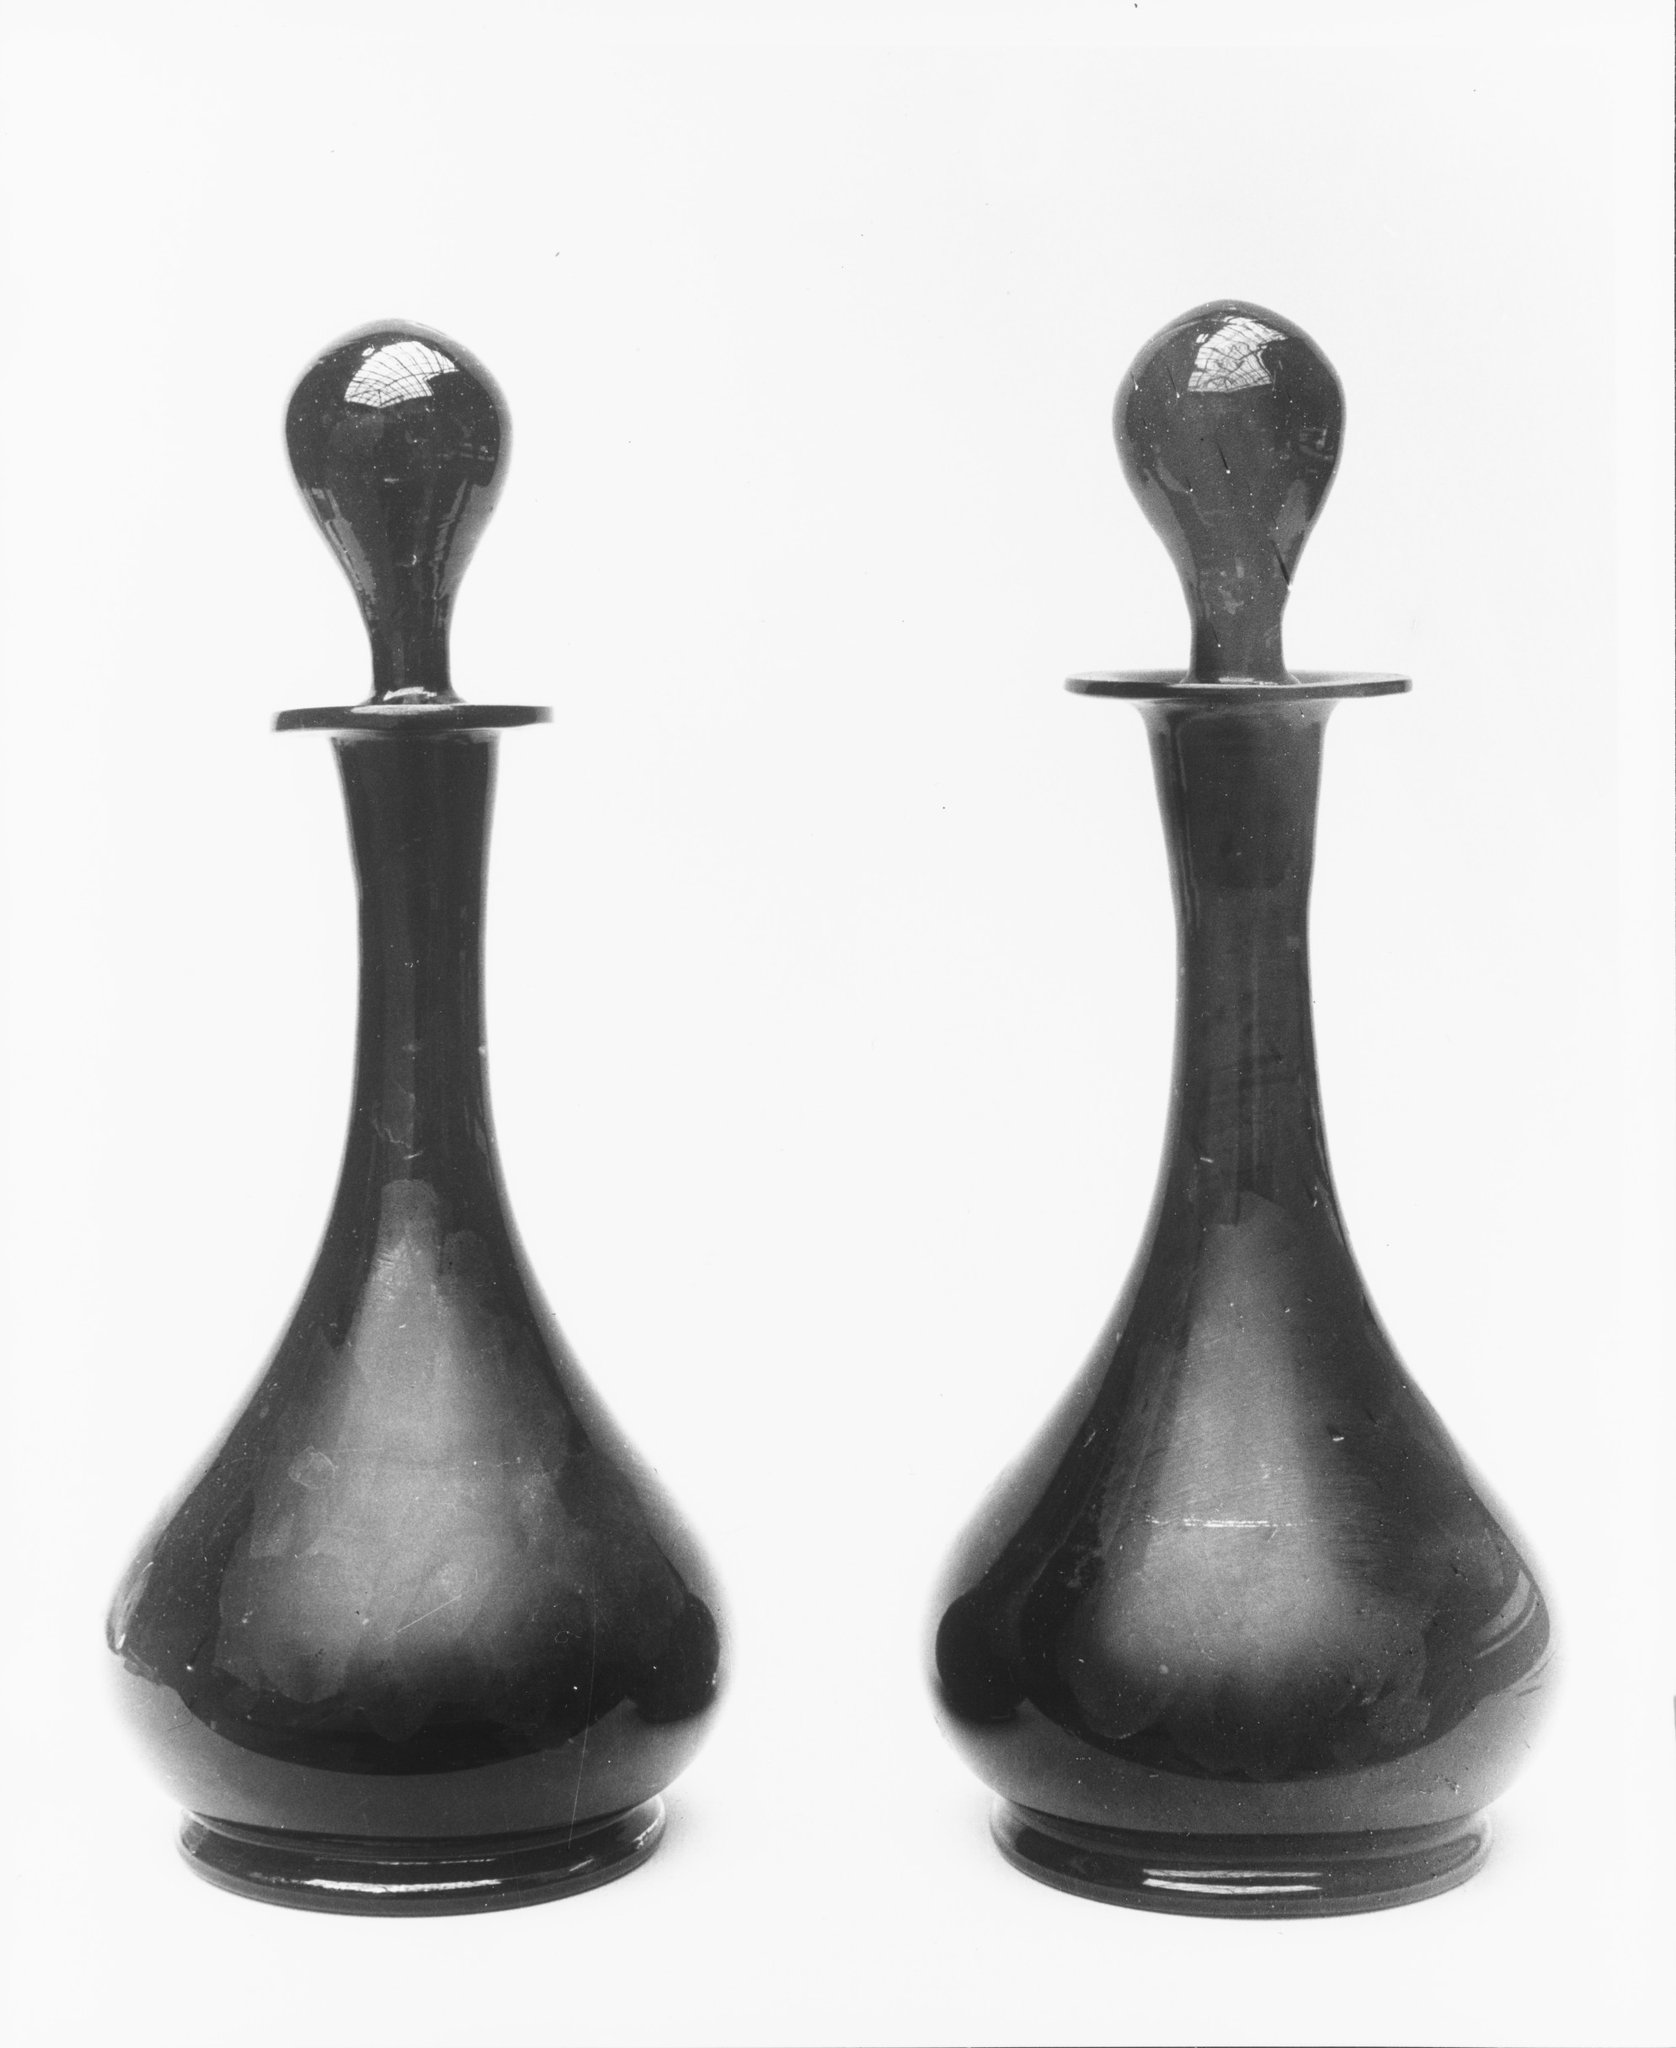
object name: cologne bottle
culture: czech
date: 1890-1900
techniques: glassblowing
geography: czech republic